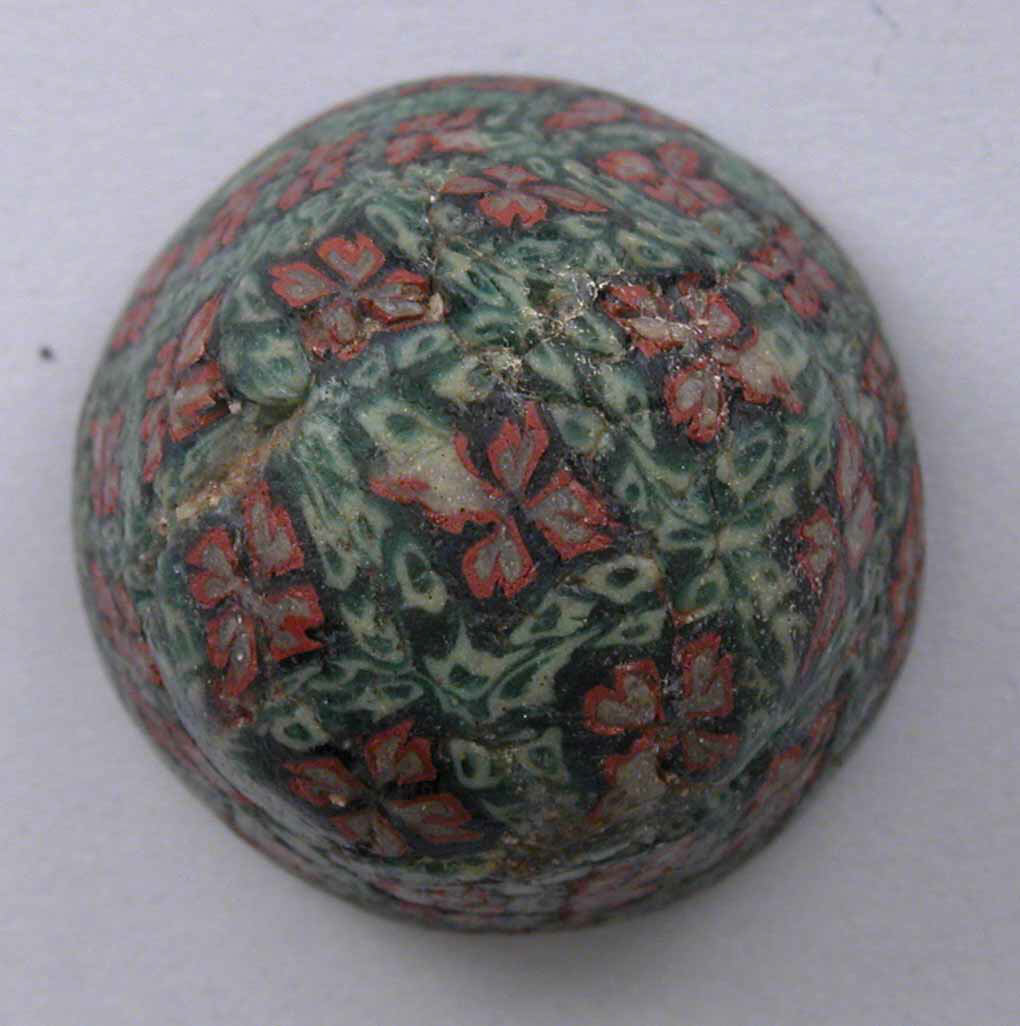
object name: gaming piece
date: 801-1000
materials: glass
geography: central islamic lands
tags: games